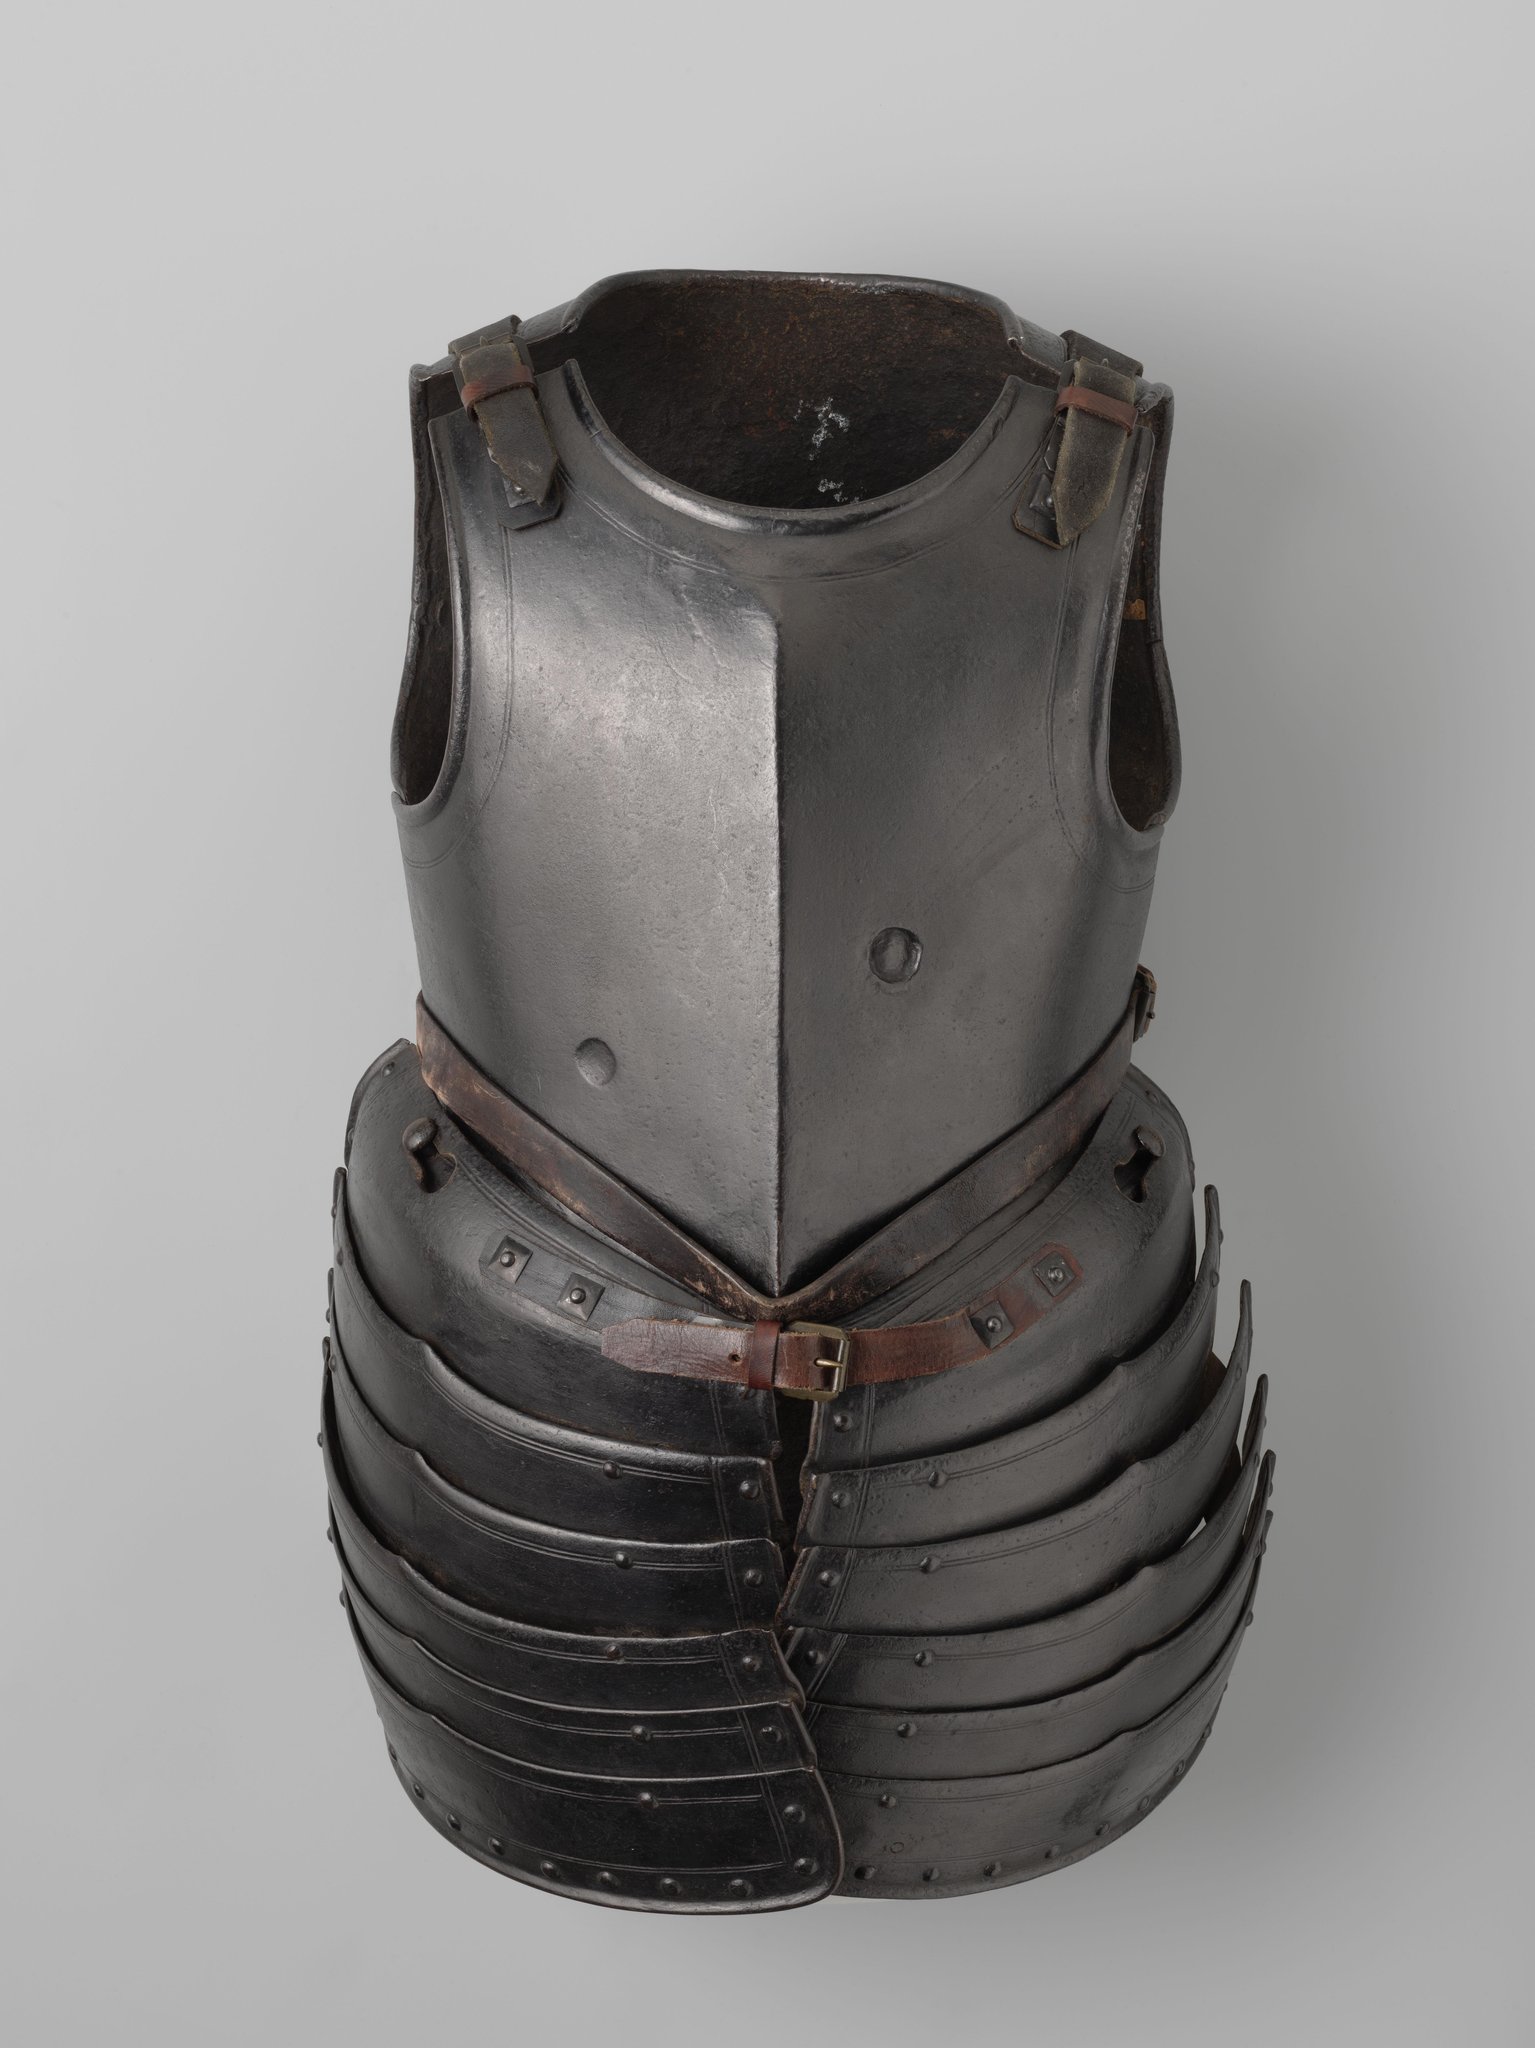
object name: breastplate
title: Borstplaat van het harnas van Piet Hein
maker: Anonymous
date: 1600-1629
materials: iron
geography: netherlands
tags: delfshaven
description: Borstplaat van het harnas van Piet Hein, met zowel links als rechts een teken dat het harnas 'scheutsvrij' oftewel bulletproof is. Twee gespen ter bevestiging van de rugplaat aan de borstplaat.